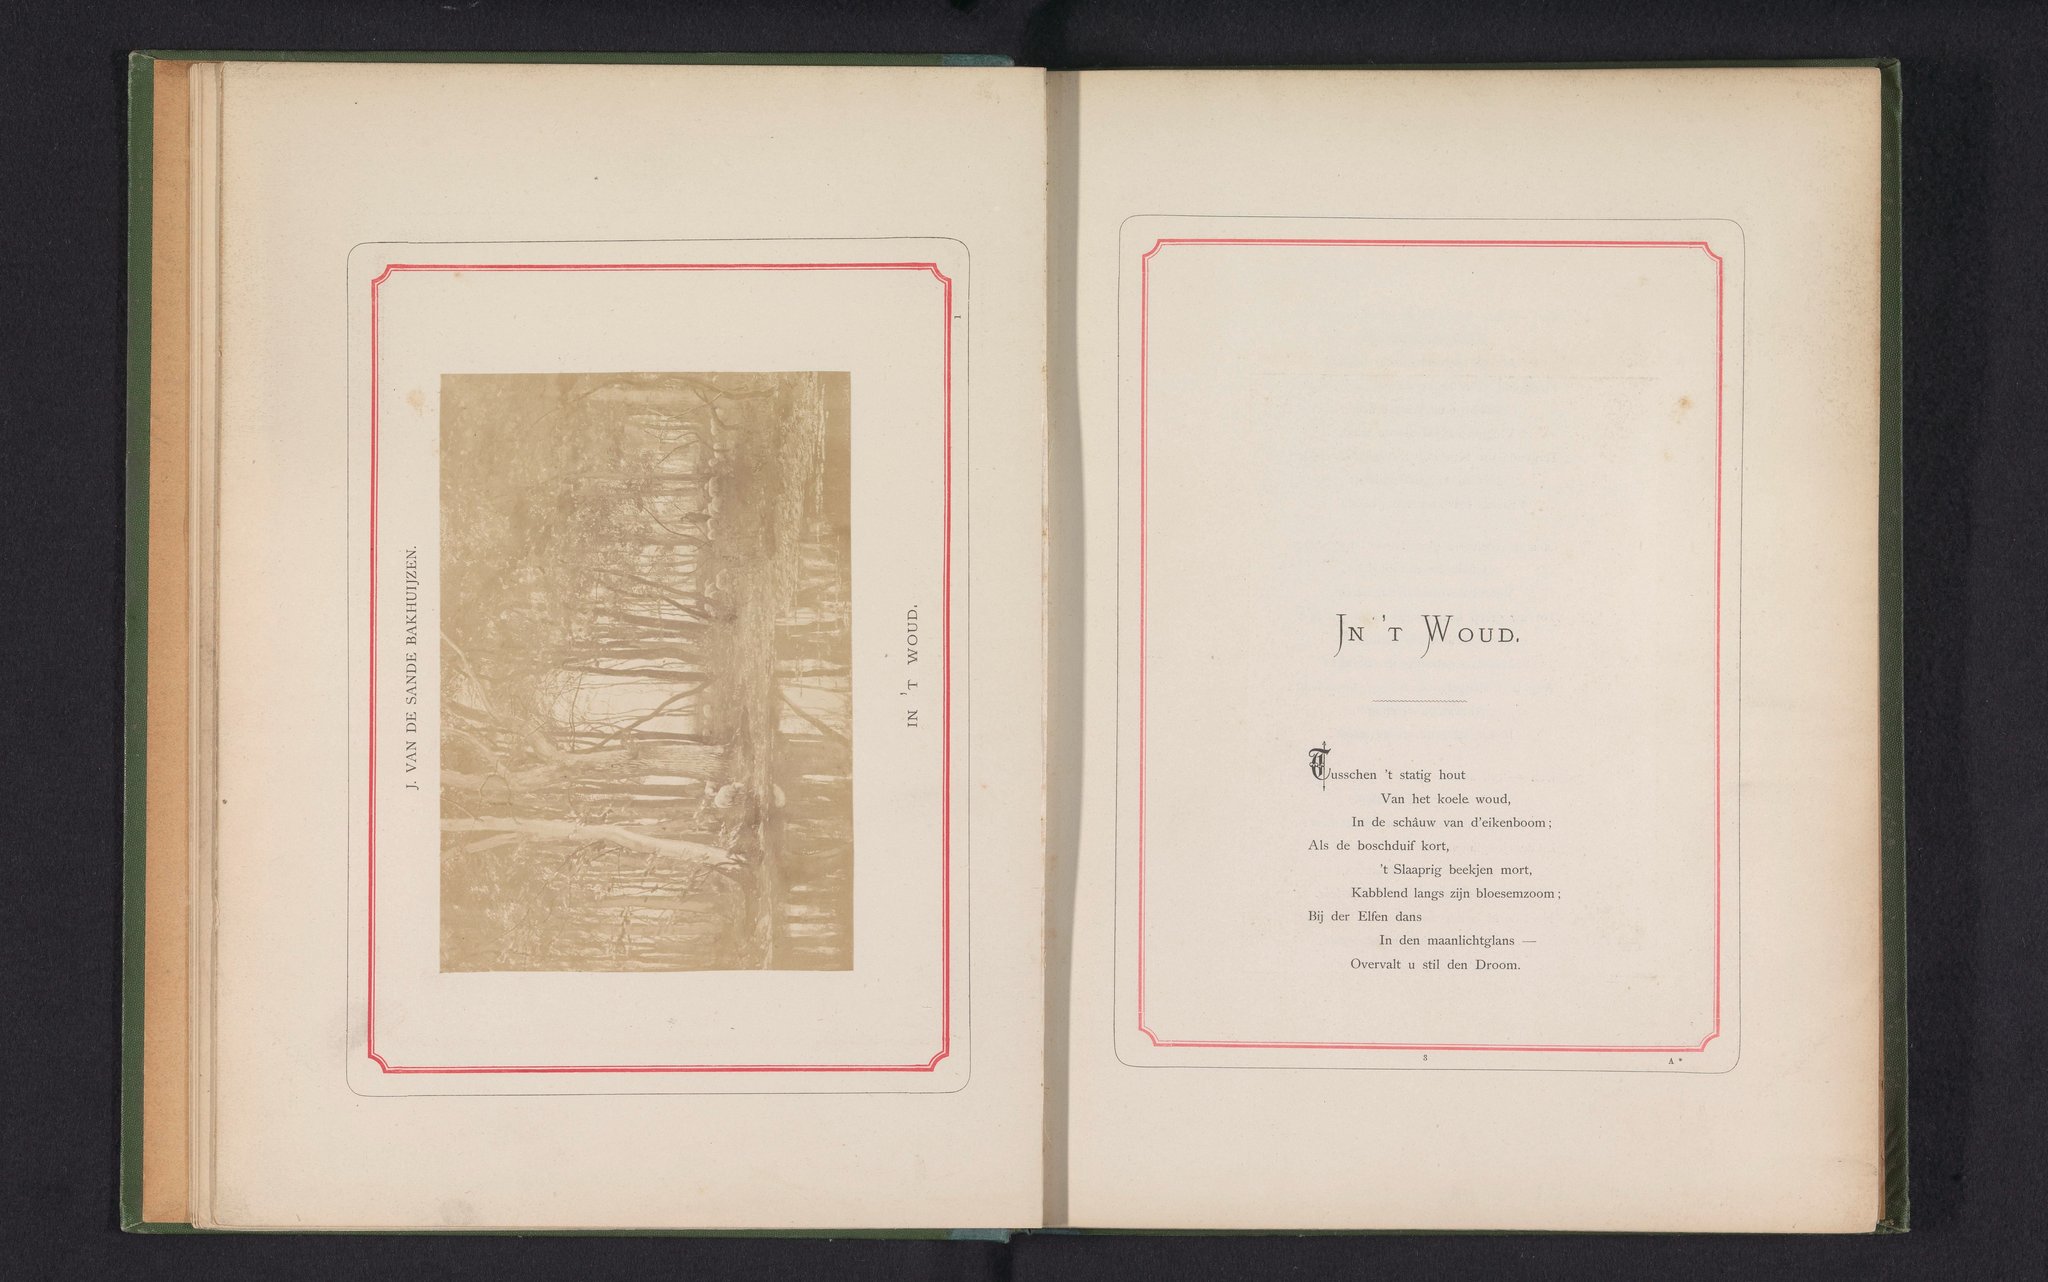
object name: reproduction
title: Fotoreproductie van een schilderij, voorstellende een kudde schapen langs een poel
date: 1868-1878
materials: photographic support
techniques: albumen print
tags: sheep, pond, pool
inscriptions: number: ‘1’